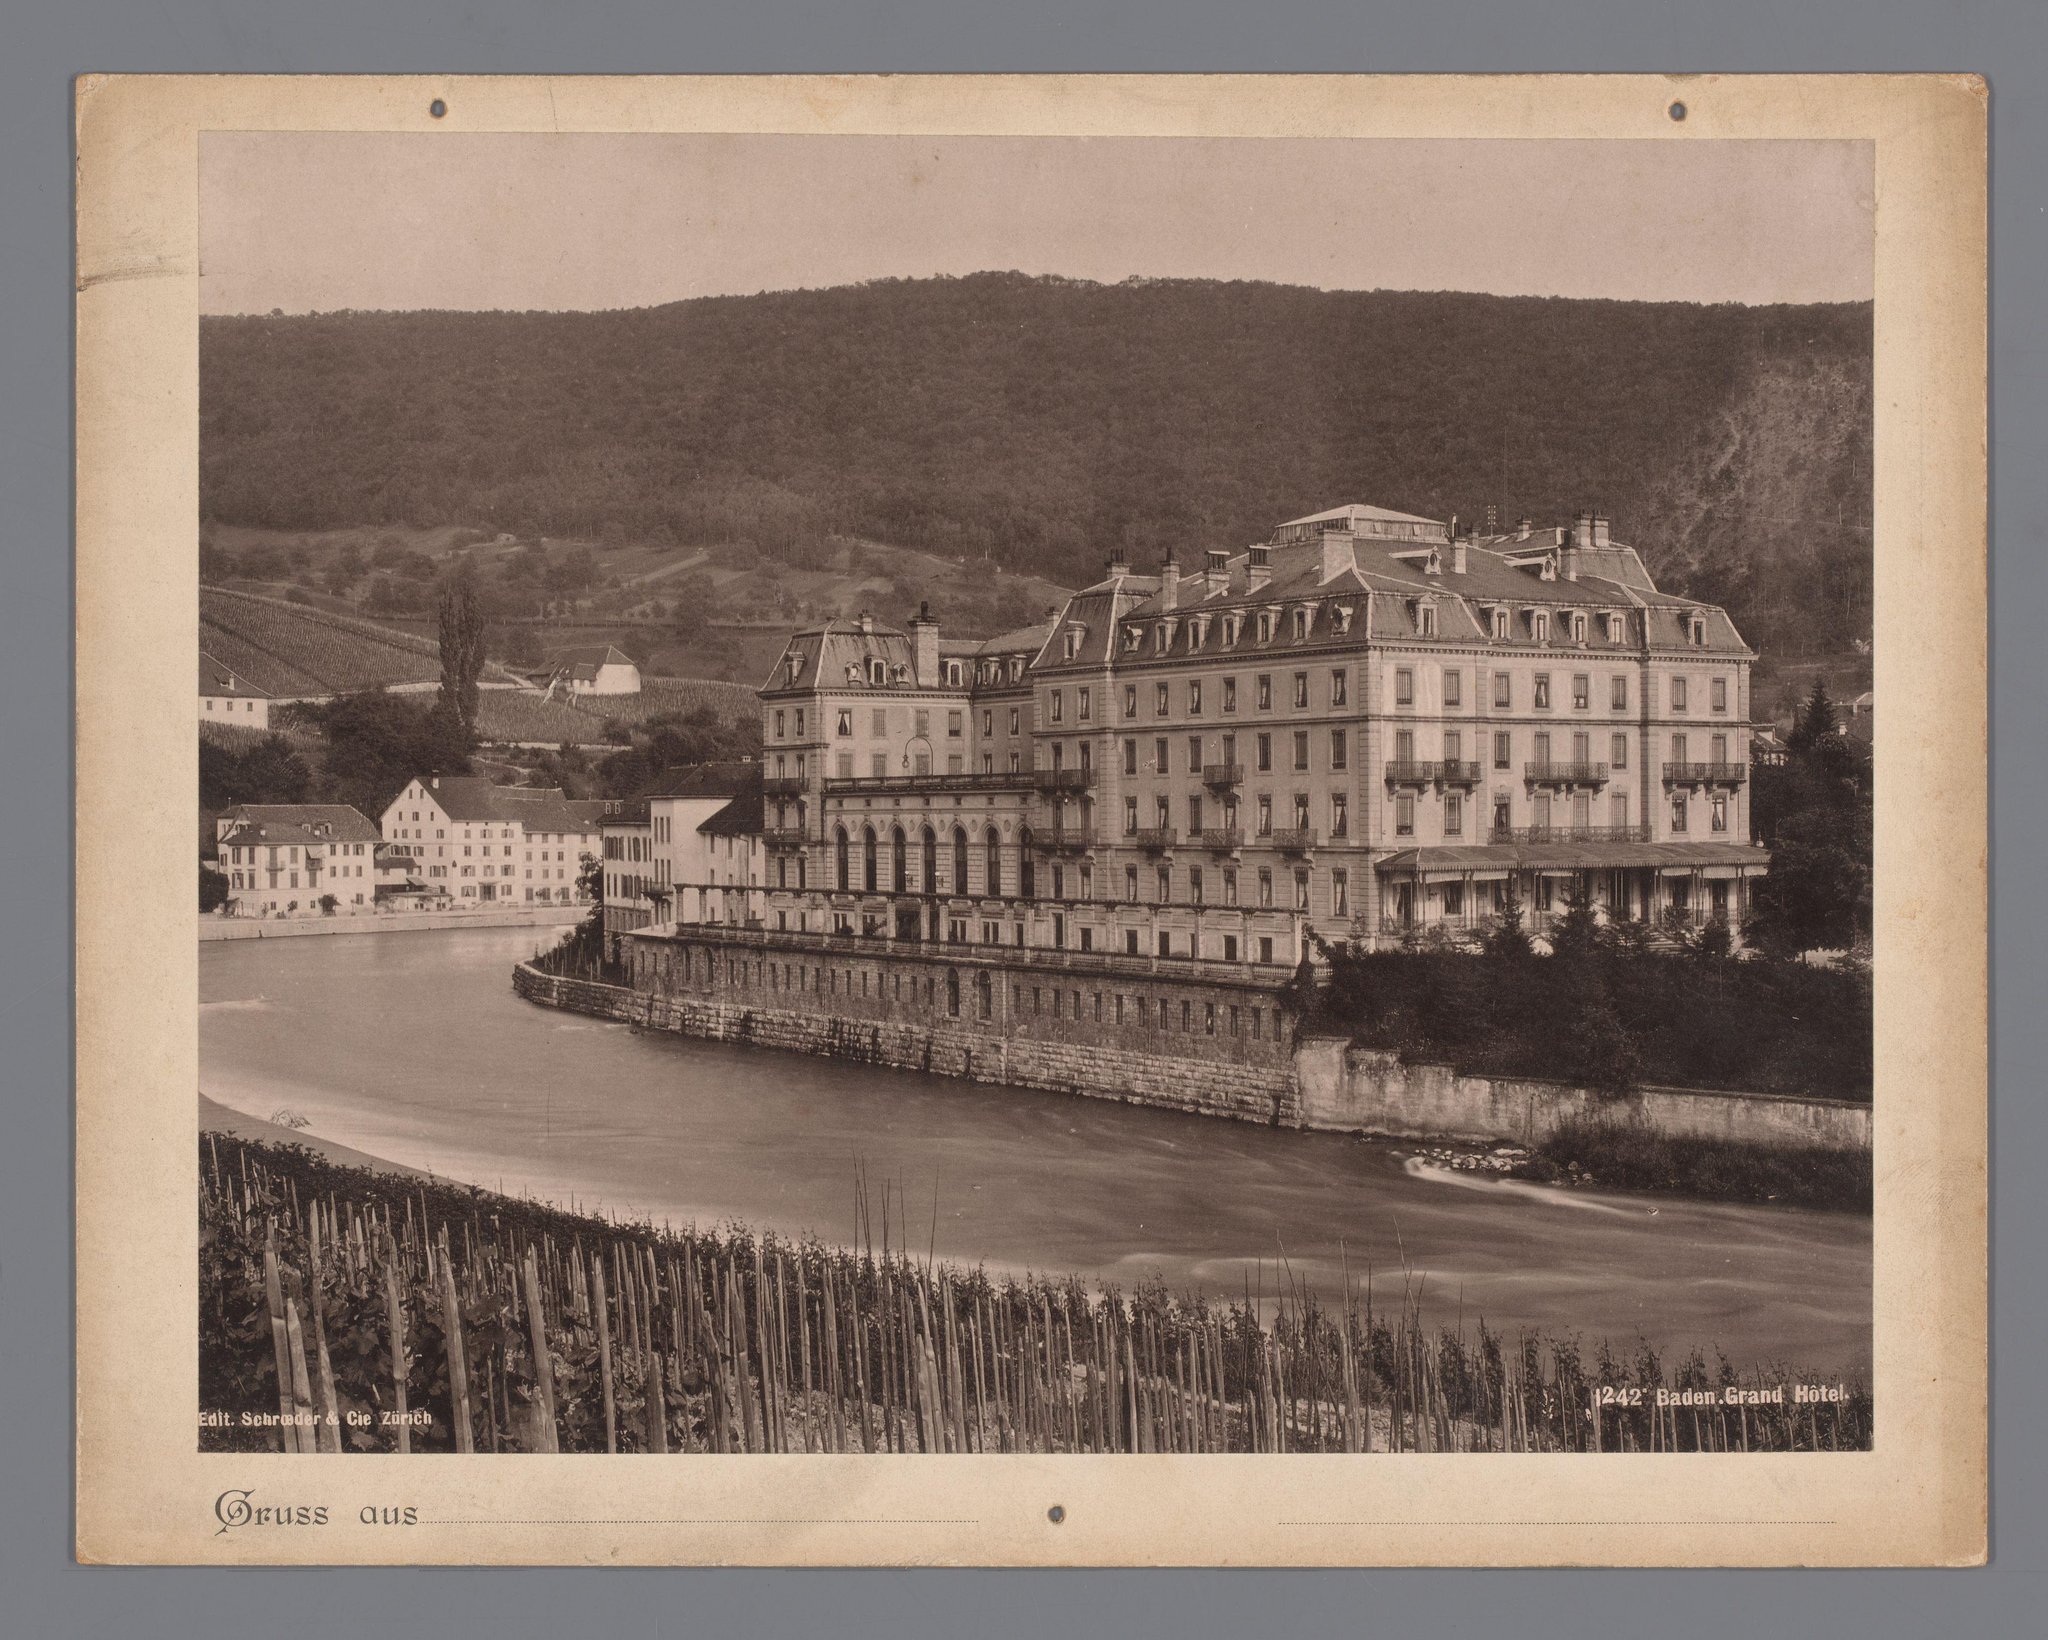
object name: photograph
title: Grand Hotel, Baden, Duitsland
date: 1880-1900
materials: cardboard, photographic support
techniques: photograph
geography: zurich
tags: germany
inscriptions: caption: ‘Gruss aus......................’, inscription: ‘1242 Baden, Grand Hôtel.’, inscription: ‘Edit. Schroeder & Cie Zürich’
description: Gezicht op een gebouw, met daarvoor een rivier.